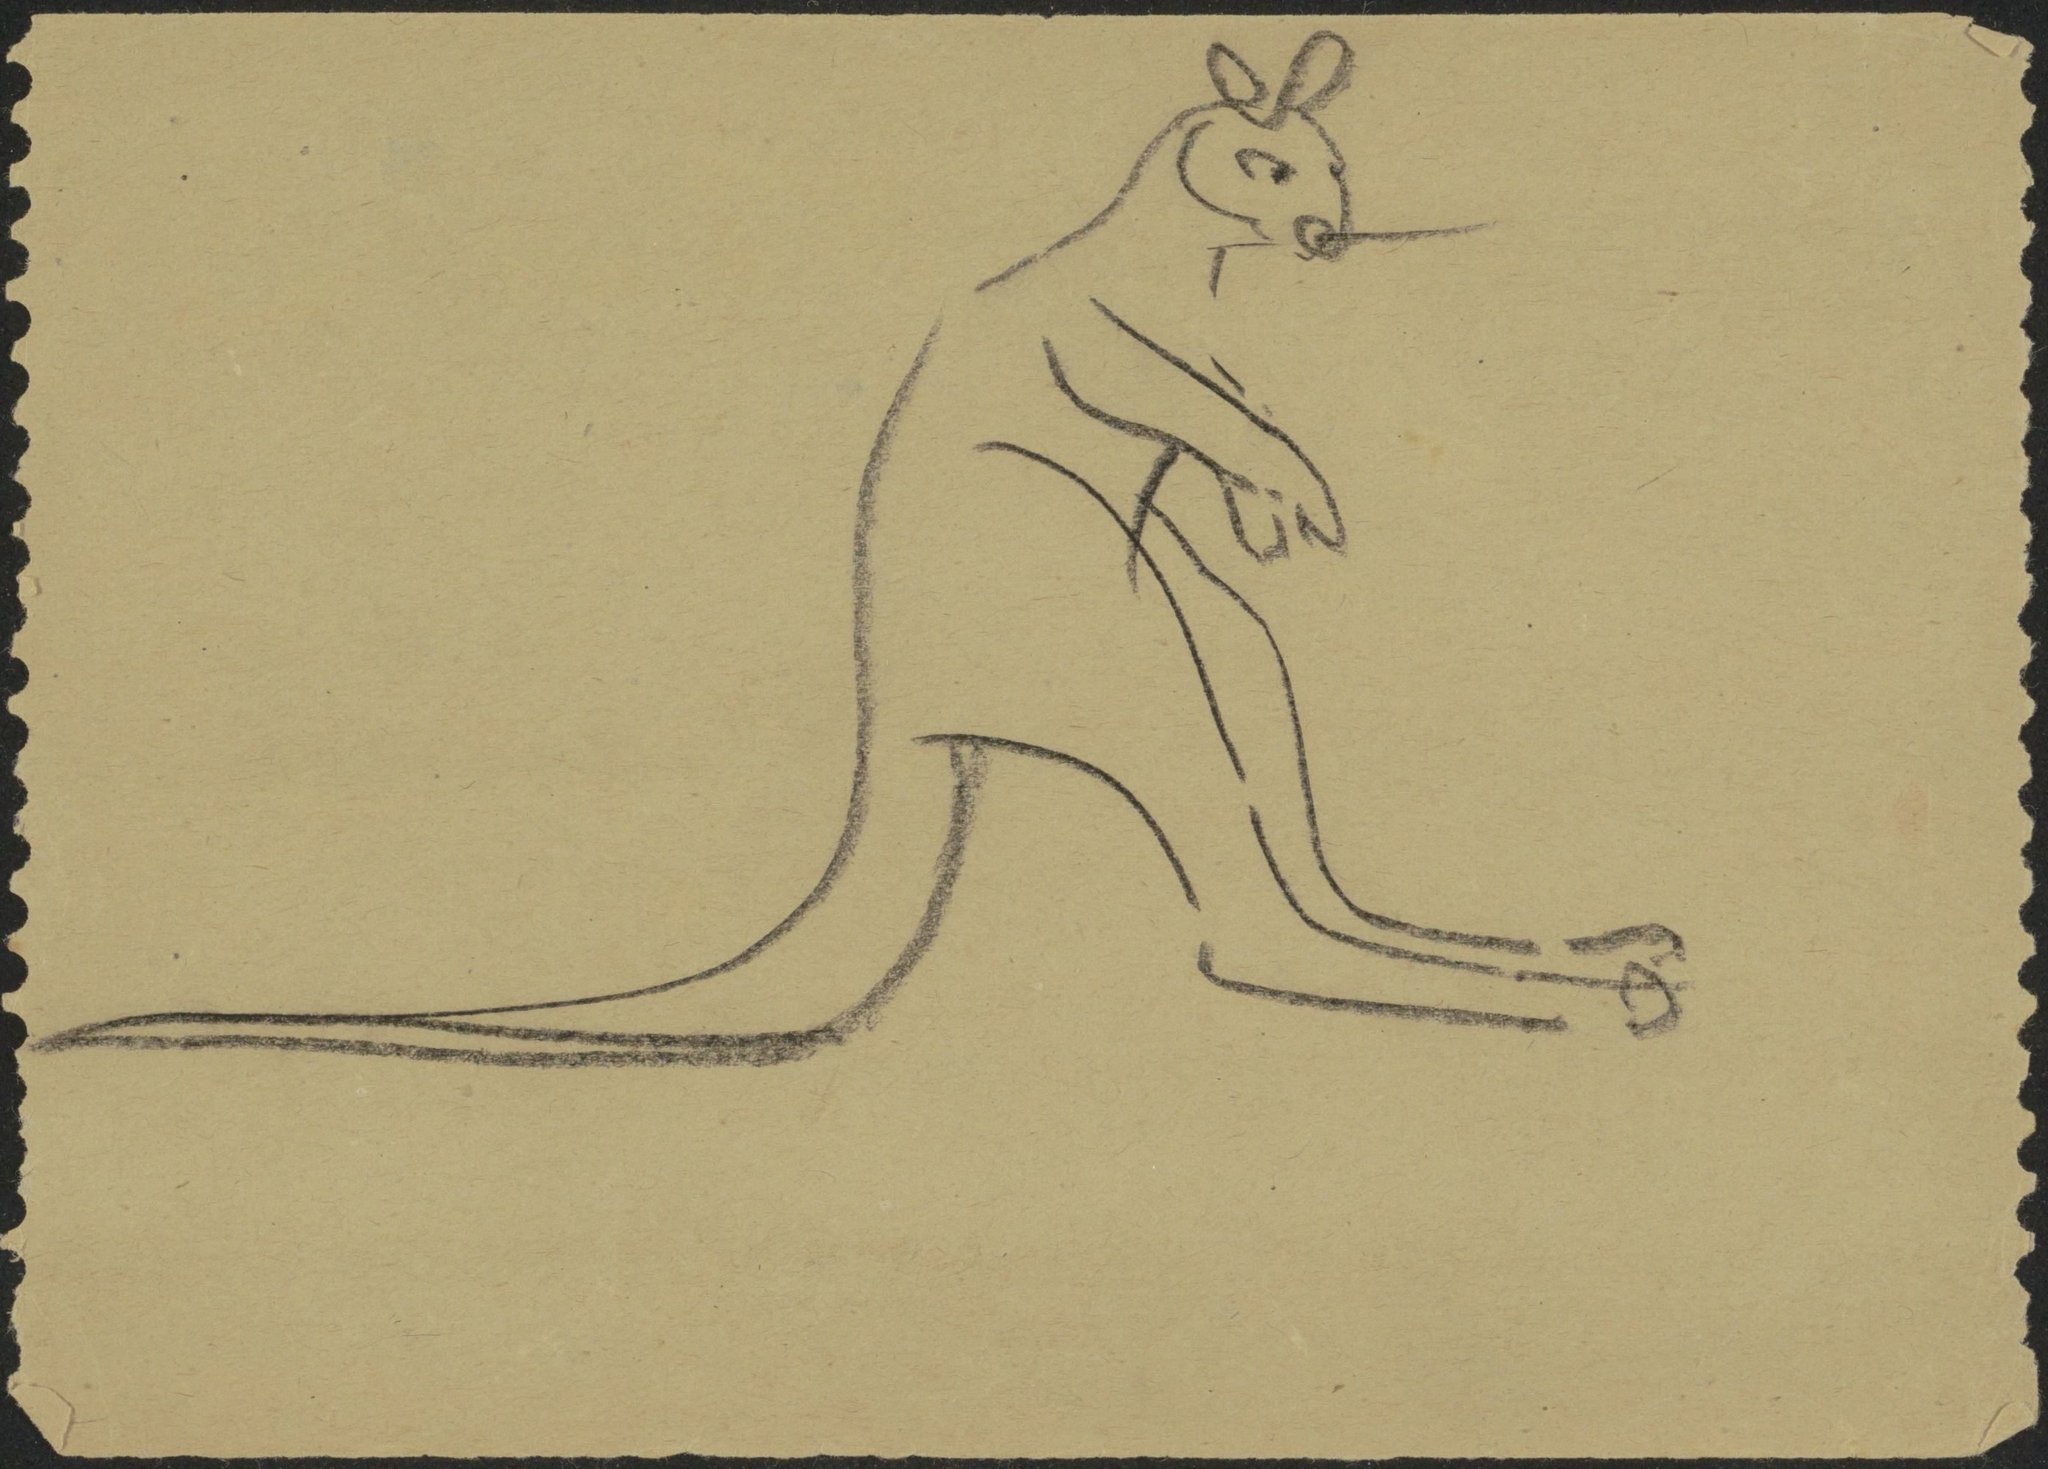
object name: drawing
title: Kangoeroe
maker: gerrit willem dijsselhof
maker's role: designer, draughtsman, print maker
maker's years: 1866-1924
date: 1904-1906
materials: chalk, paper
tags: other mammals (with name)